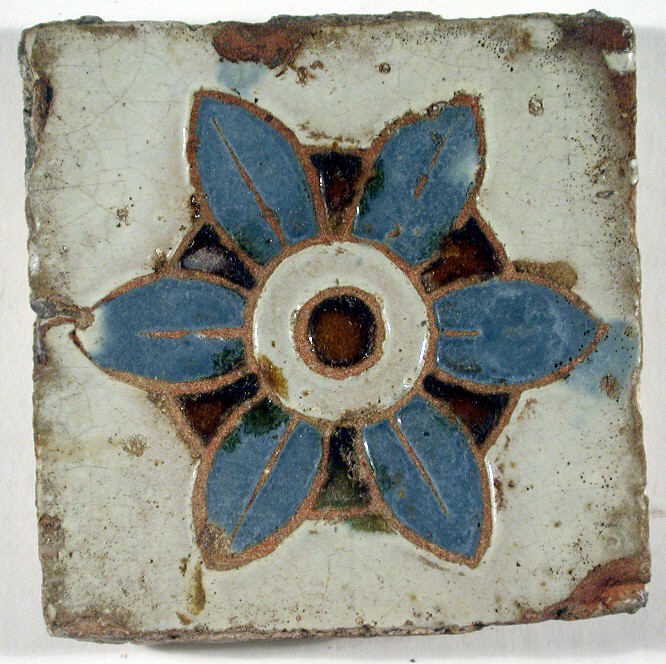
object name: pavement tile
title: Pavement tiles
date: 1501-1700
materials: earthenware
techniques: glazing